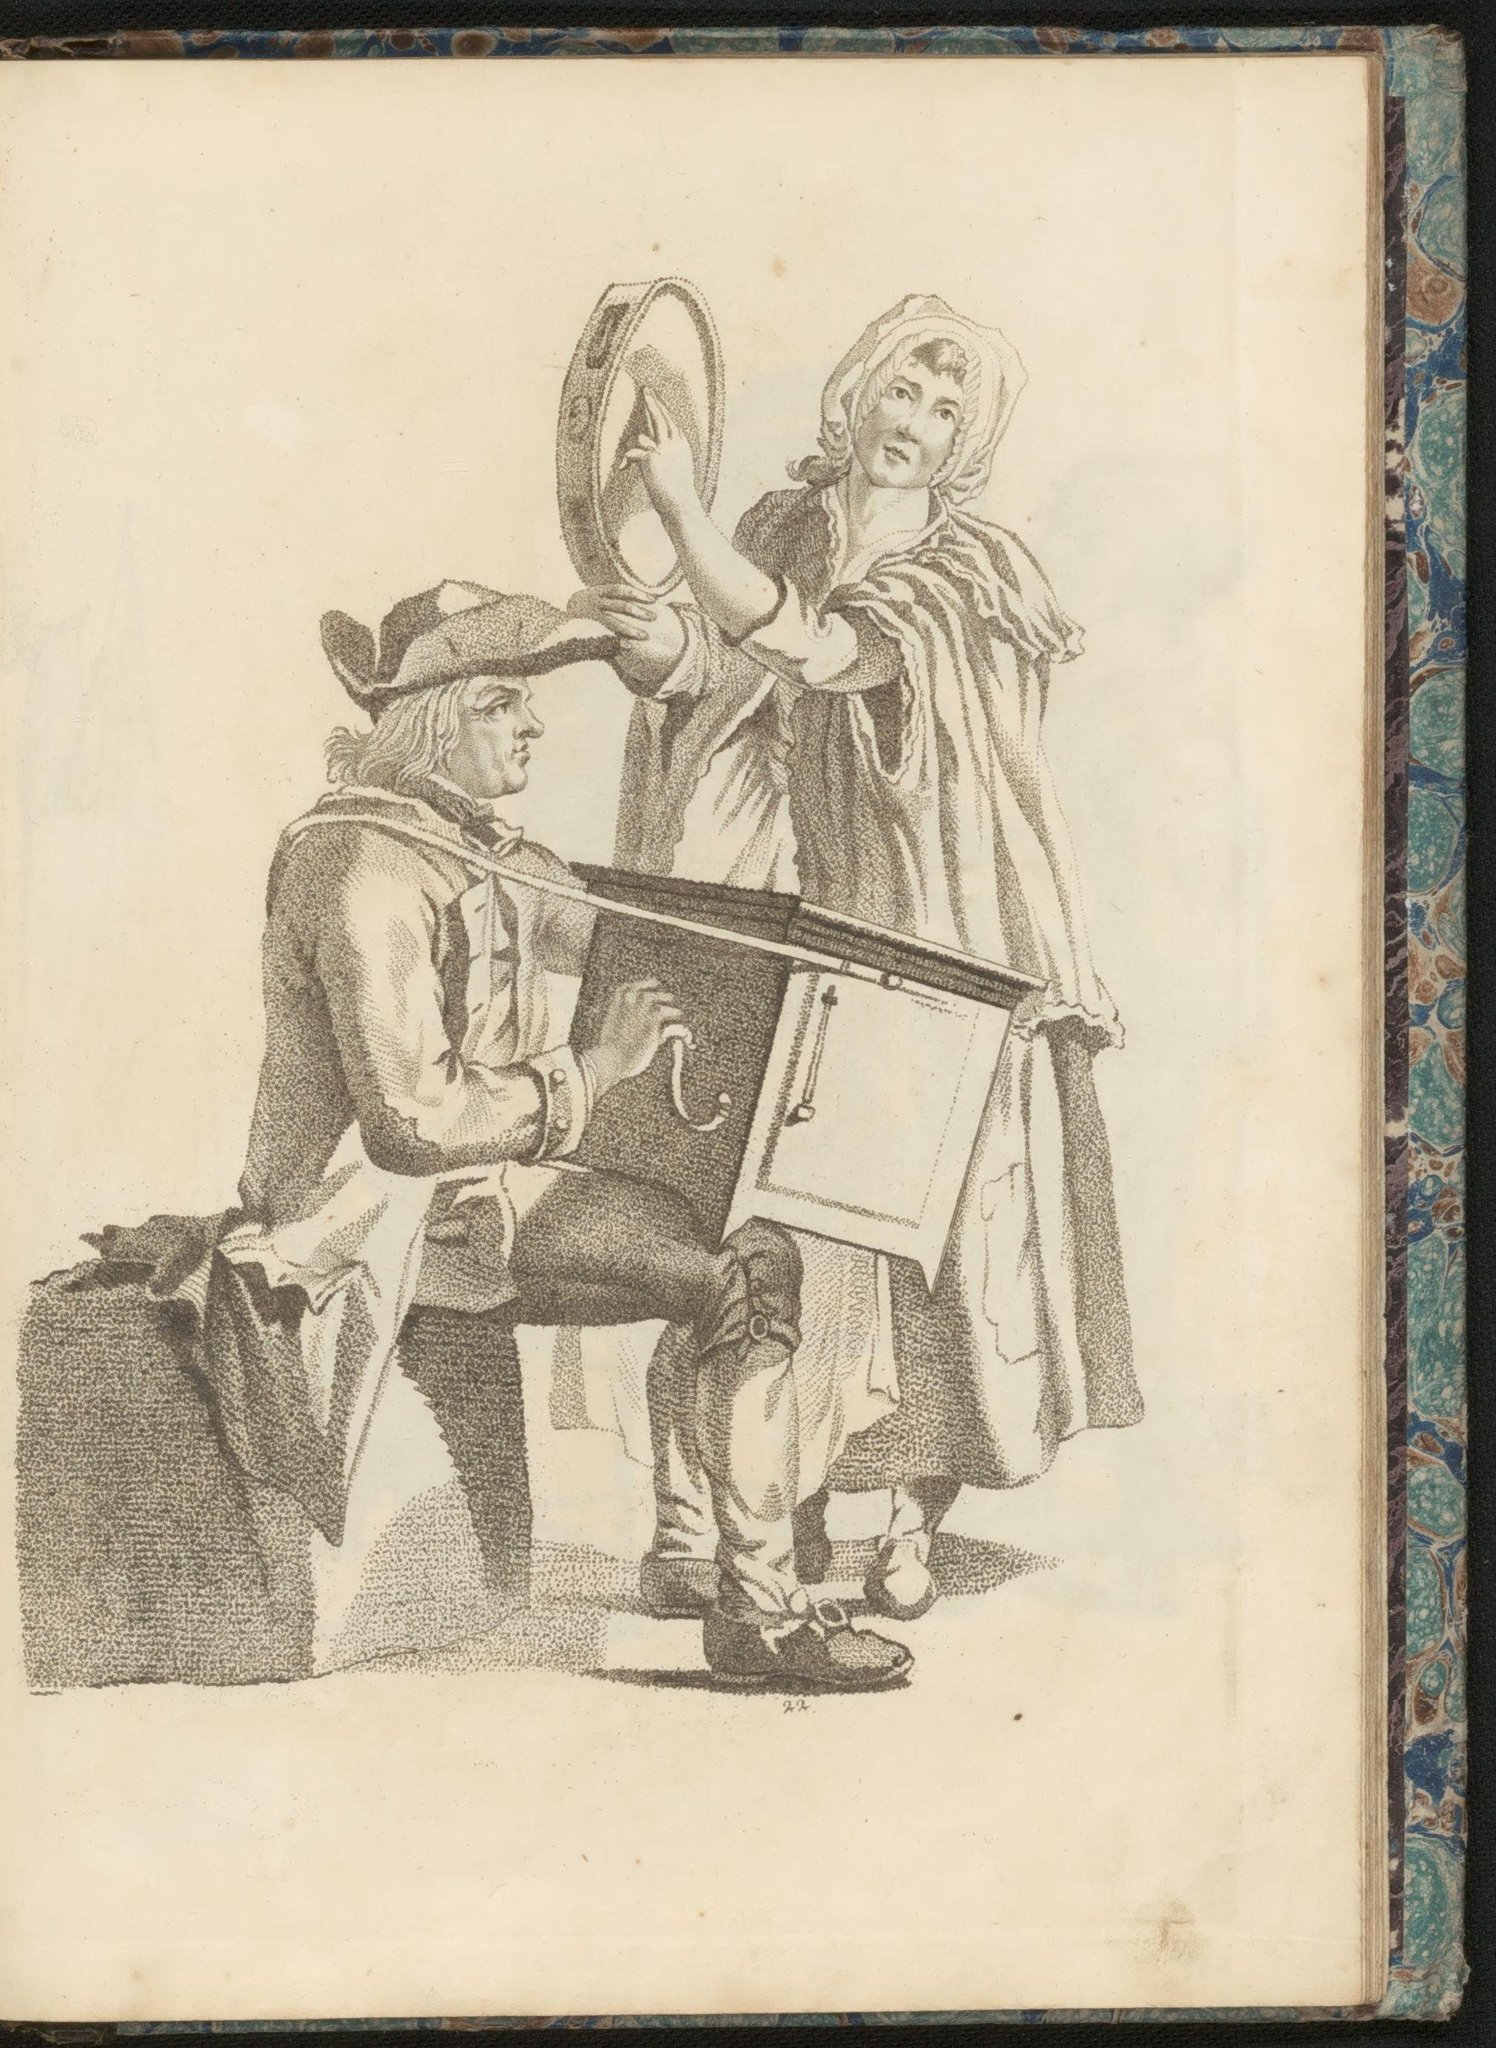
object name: print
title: Draaiorgelspeler en vrouw met tamboerijn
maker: mathias de sallieth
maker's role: print maker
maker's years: 1749-1791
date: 1772-1791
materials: paper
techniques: printmaking, etching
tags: tambourine, barrel-organ player, popular music, street music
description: De prent verscheen vanaf 1818 tevens als onderdeel van een 33-delige reeks prenten door Mathias de Sallieth, samengebonden in: Perkois, Jacobus, Prins, Johannes Huibert. Verzameling van verschillende gekleede mans- en vrouwenstanden, ter oefening van jonge schilders en liefhebbers. Rotterdam: Johannes Immerzeel, 1818. Alle verso-bladen uit dit prentalbum zijn blanco.